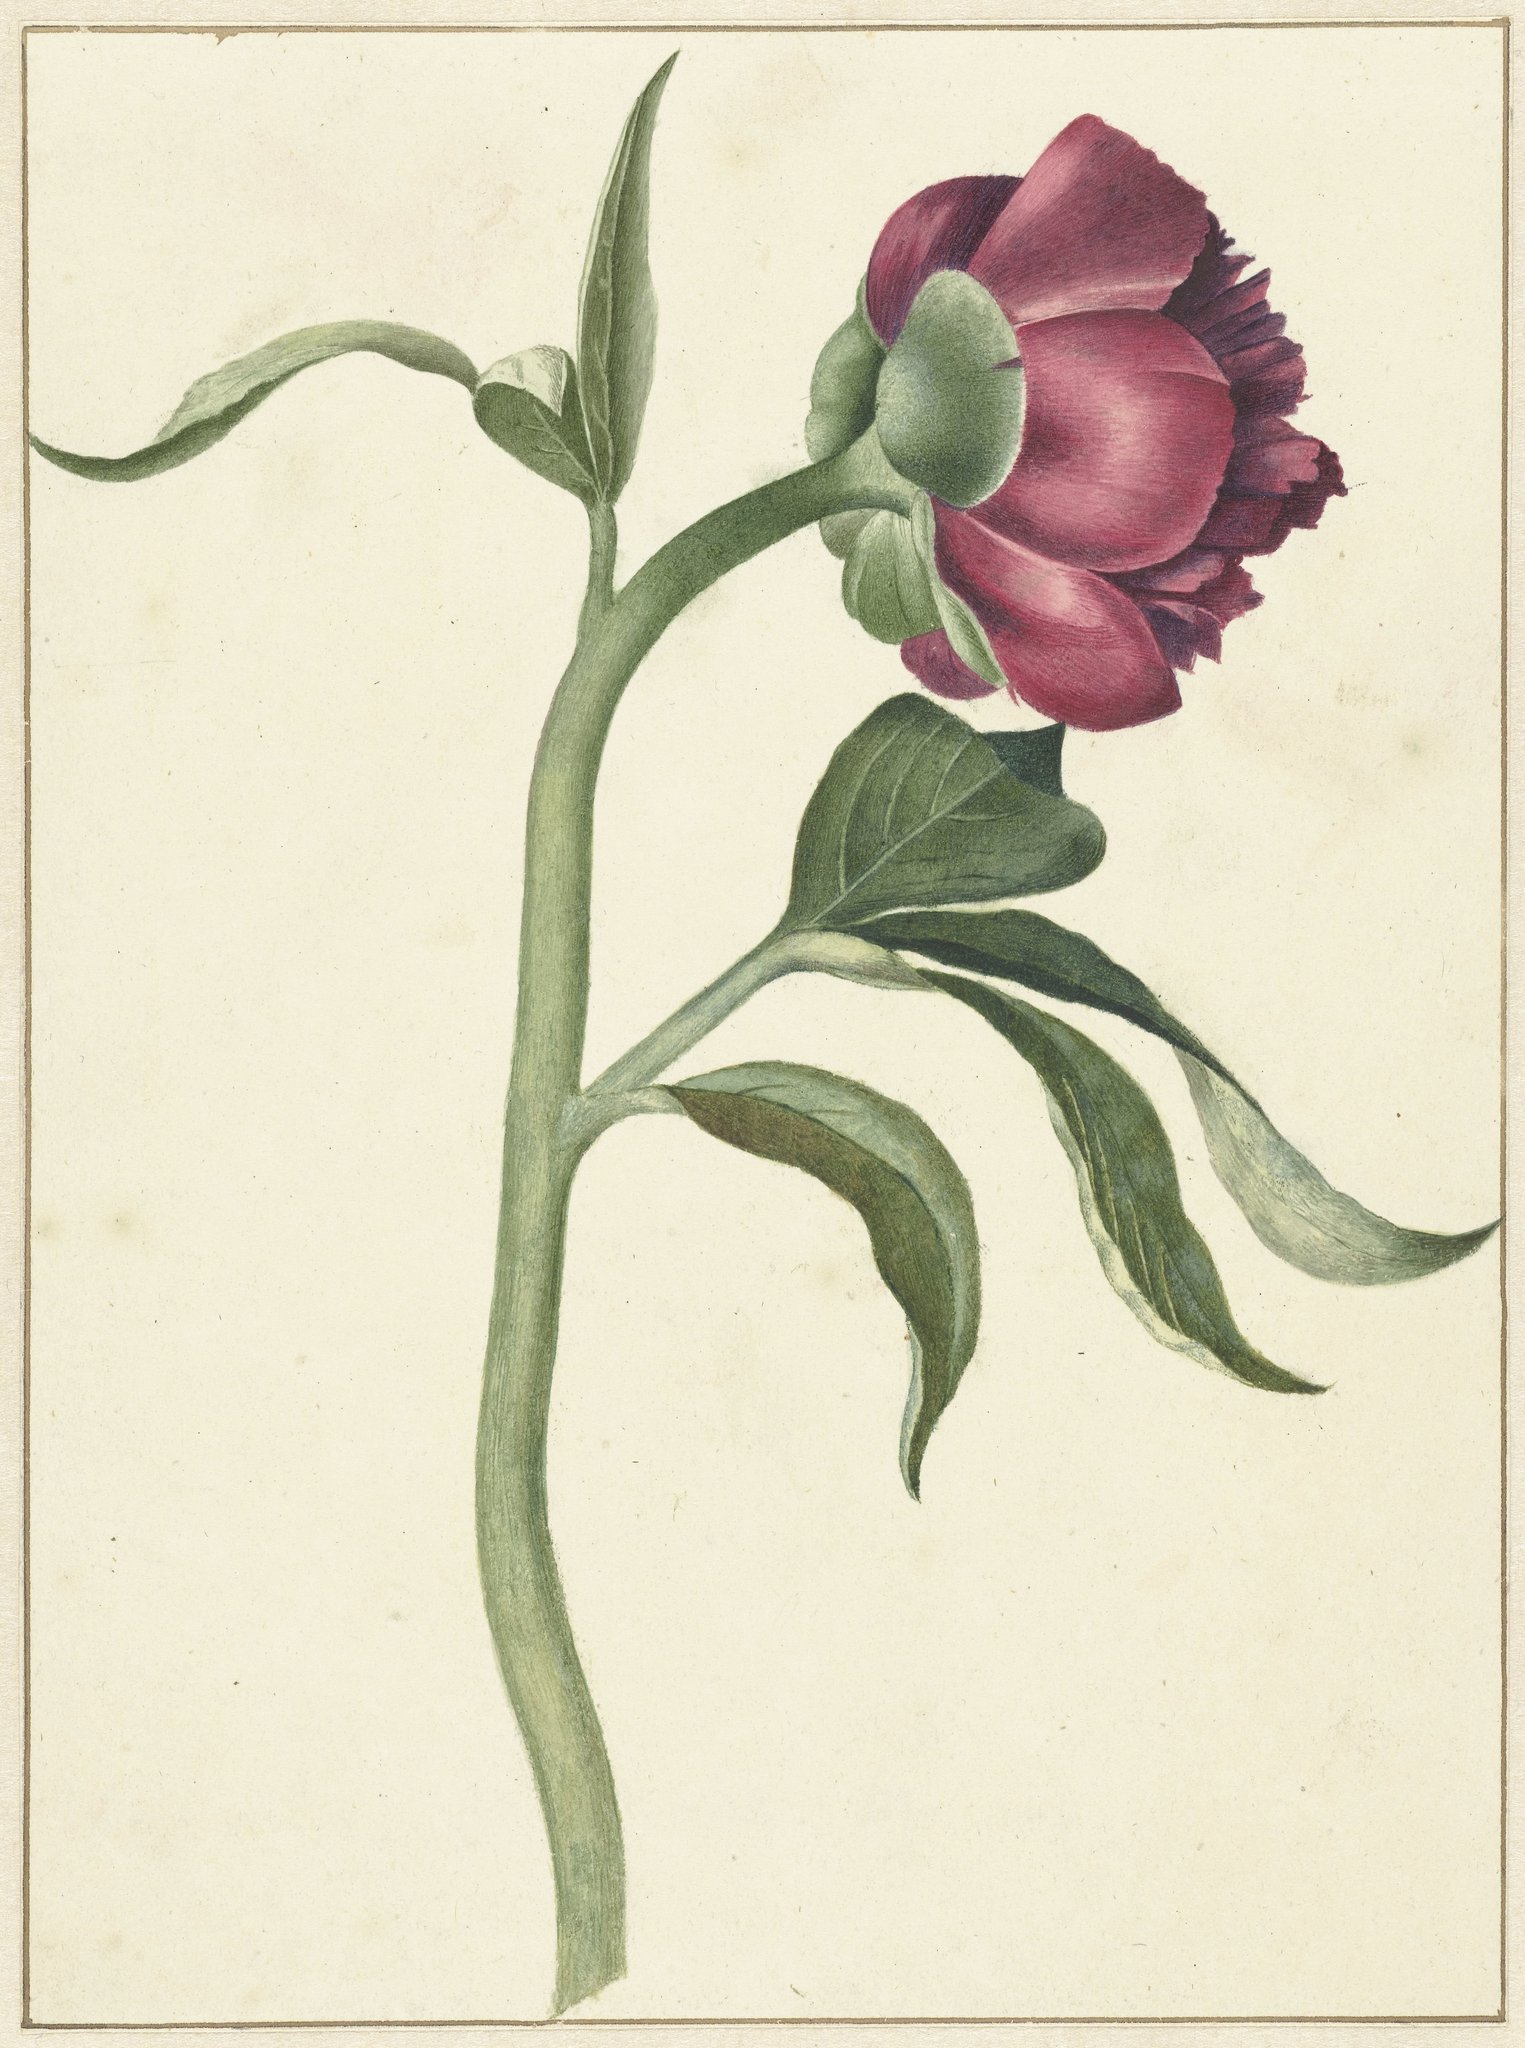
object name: drawing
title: Bloem van de pioenroos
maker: c.j. kruimel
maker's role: draughtsman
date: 1700-1800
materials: paper, watercolor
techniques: brush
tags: plants and herbs: peony